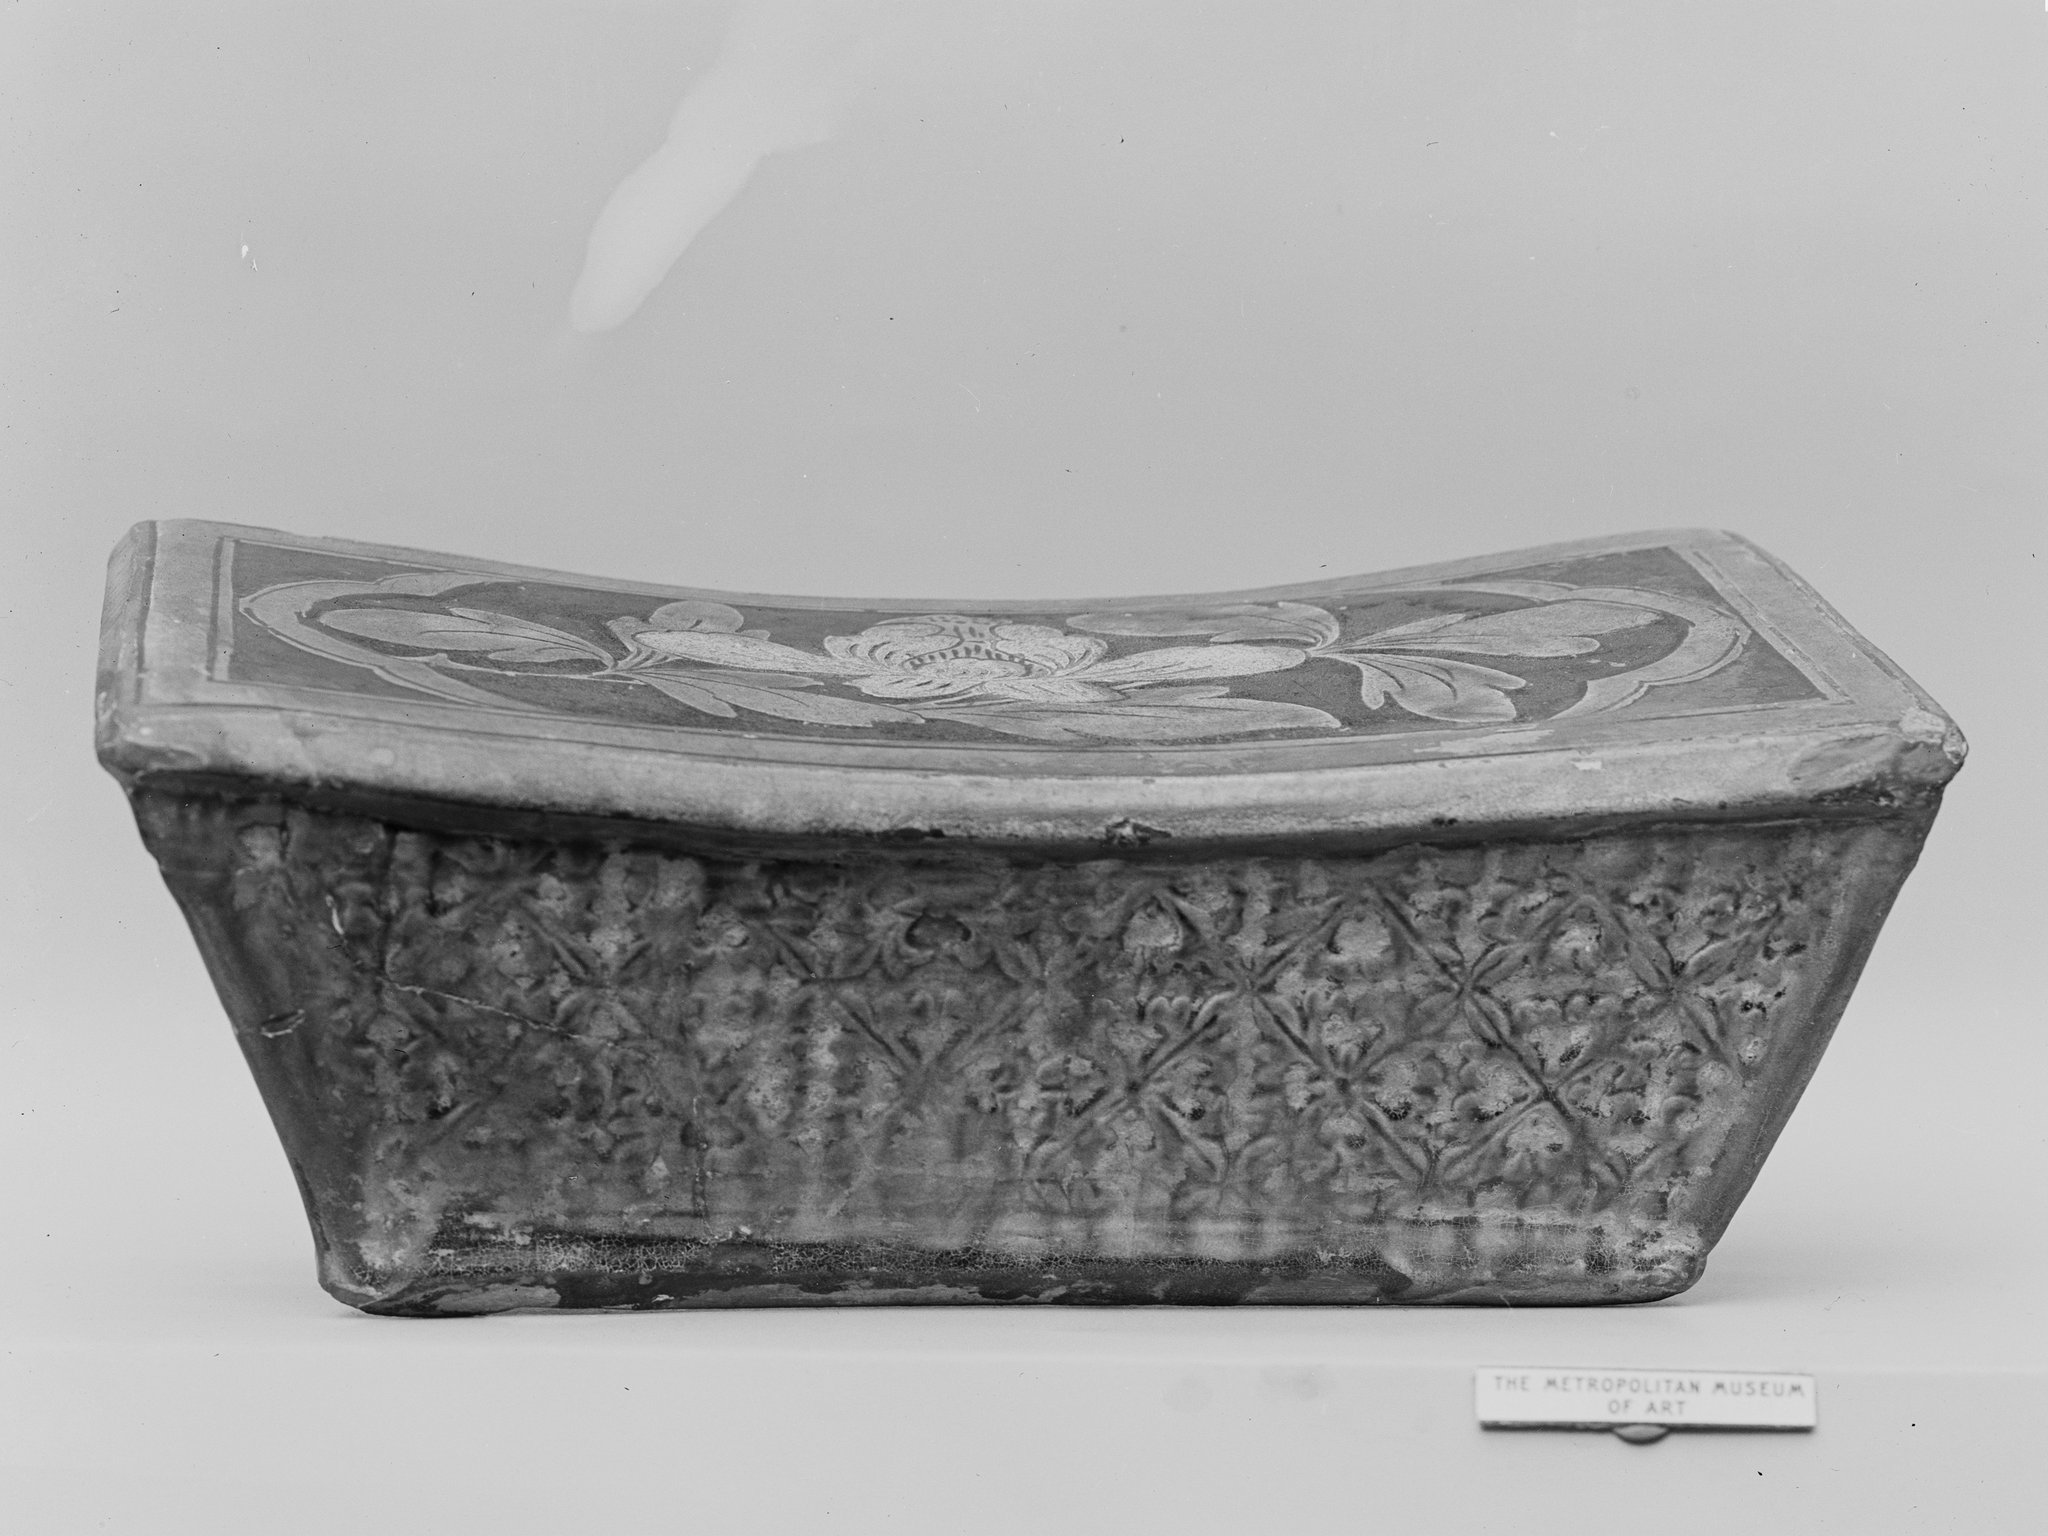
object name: pillow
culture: chinese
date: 960-1279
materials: pottery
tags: flowers